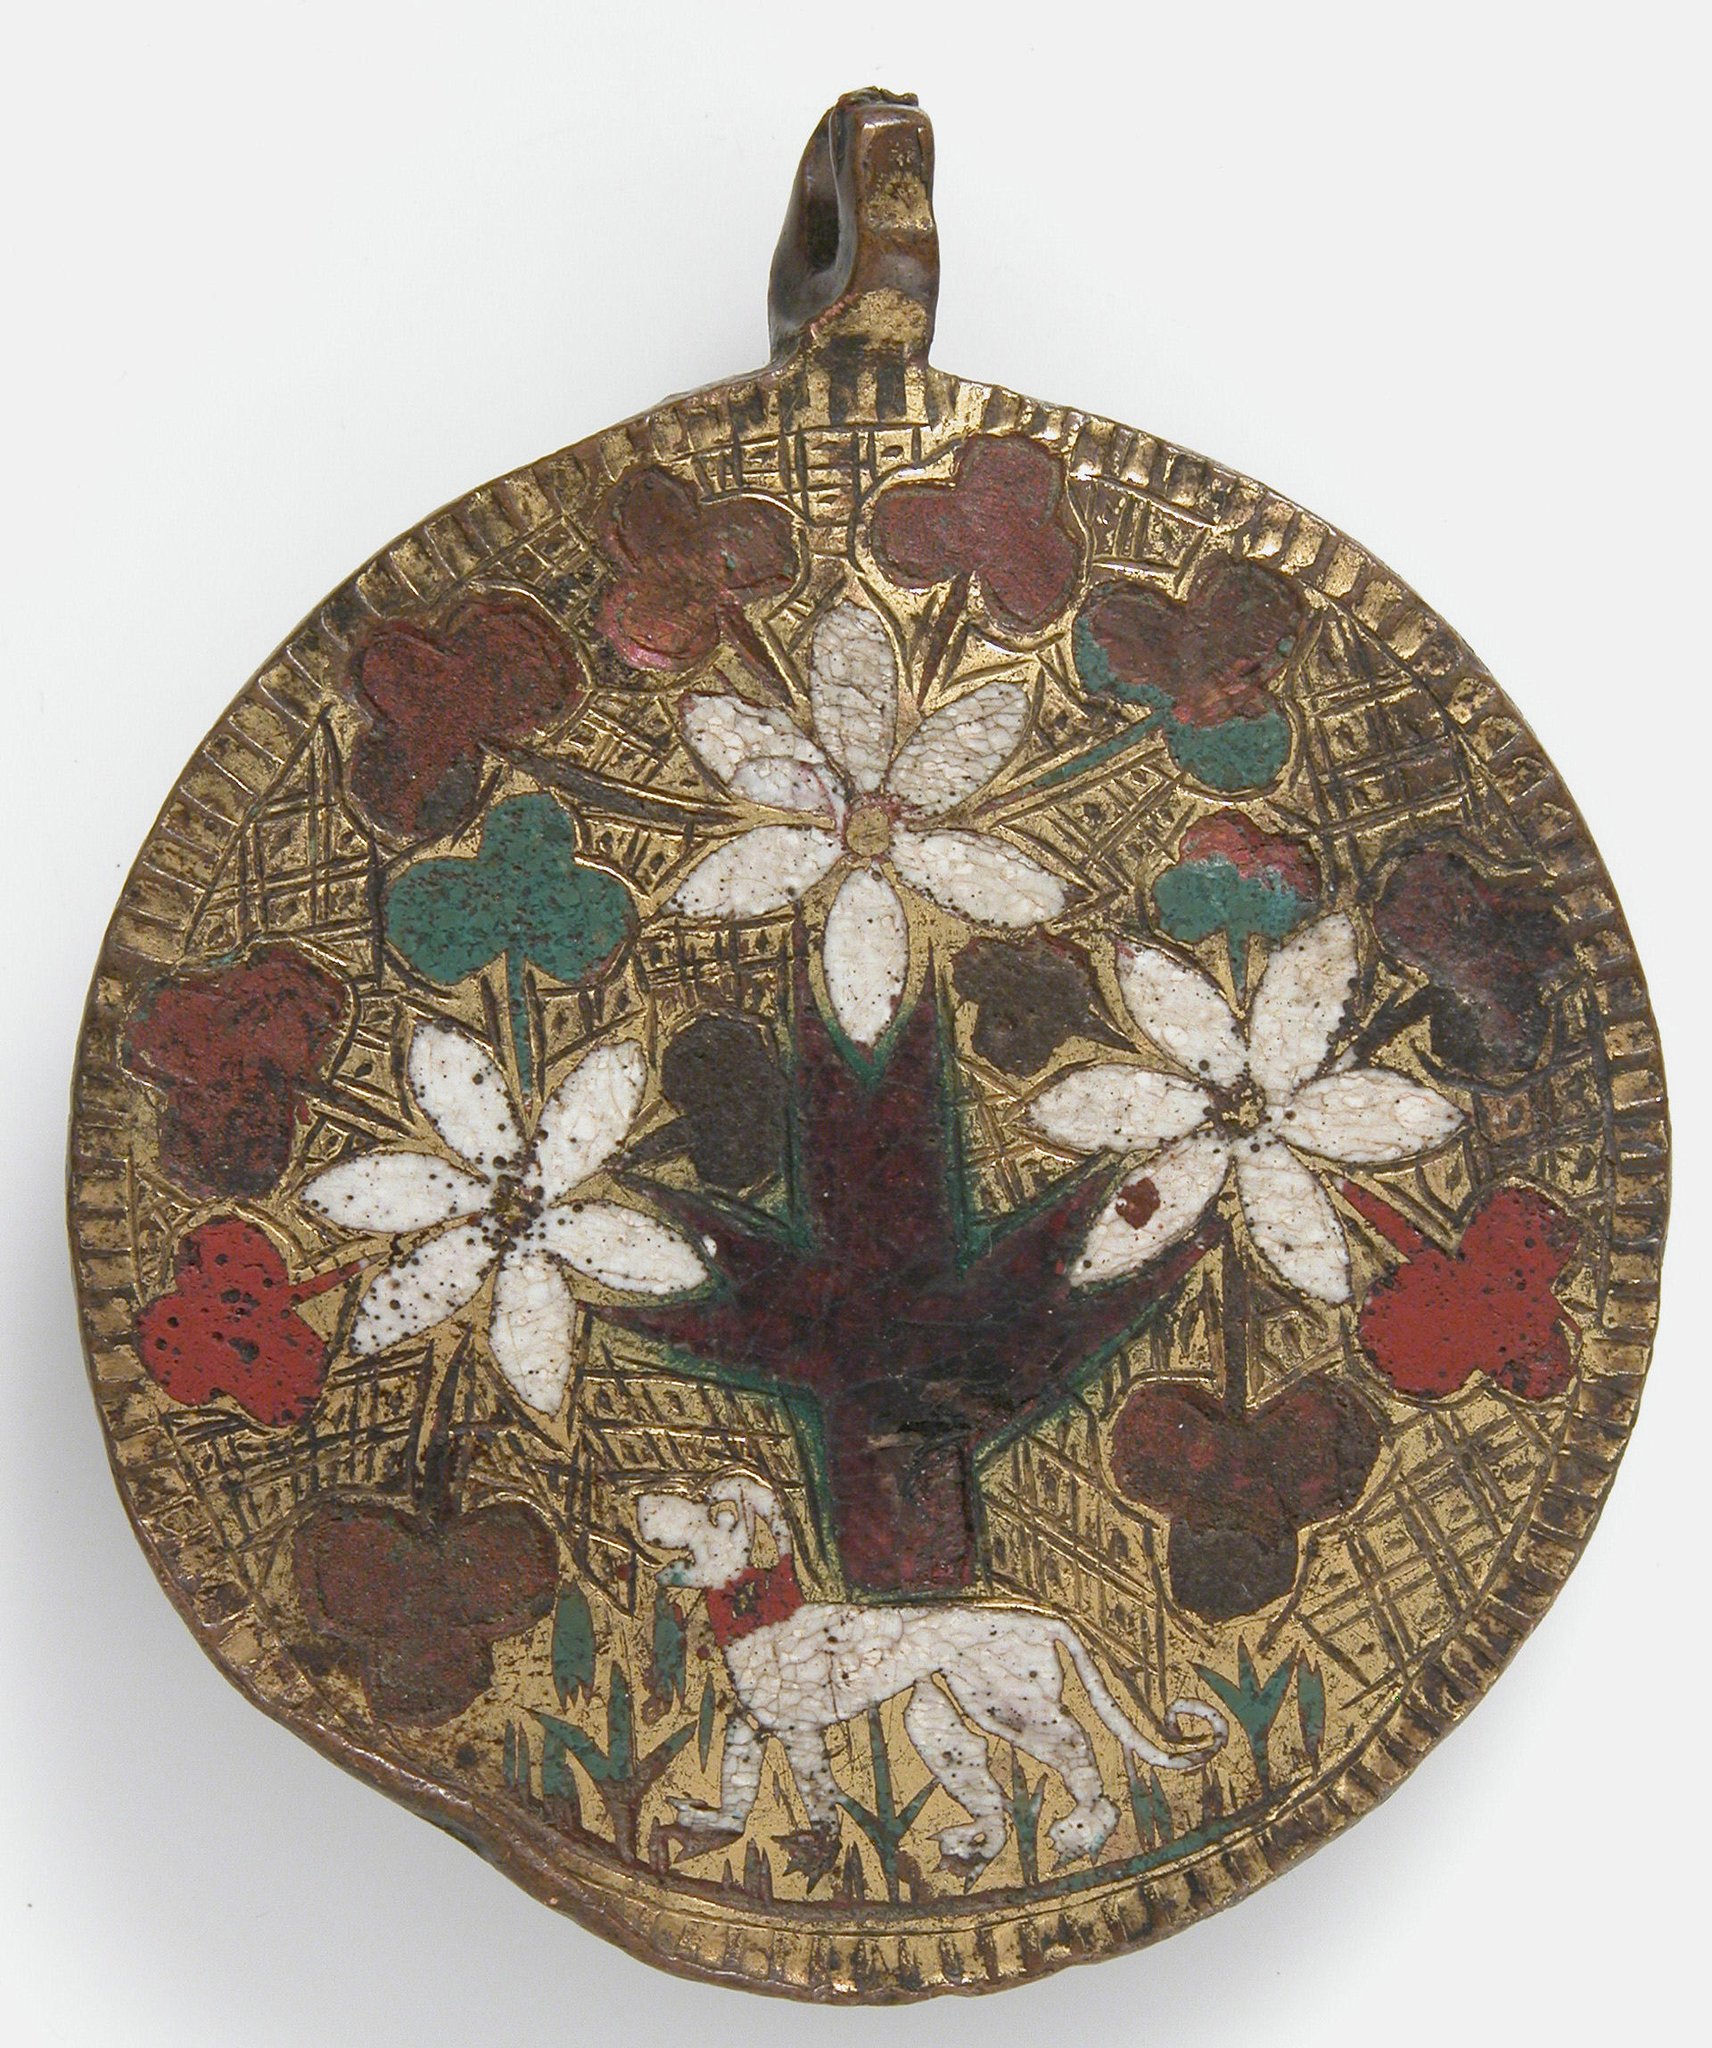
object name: pendant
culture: french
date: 1301-1400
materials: copper, enamel, gilt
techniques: enamel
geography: france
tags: dogs,flowers